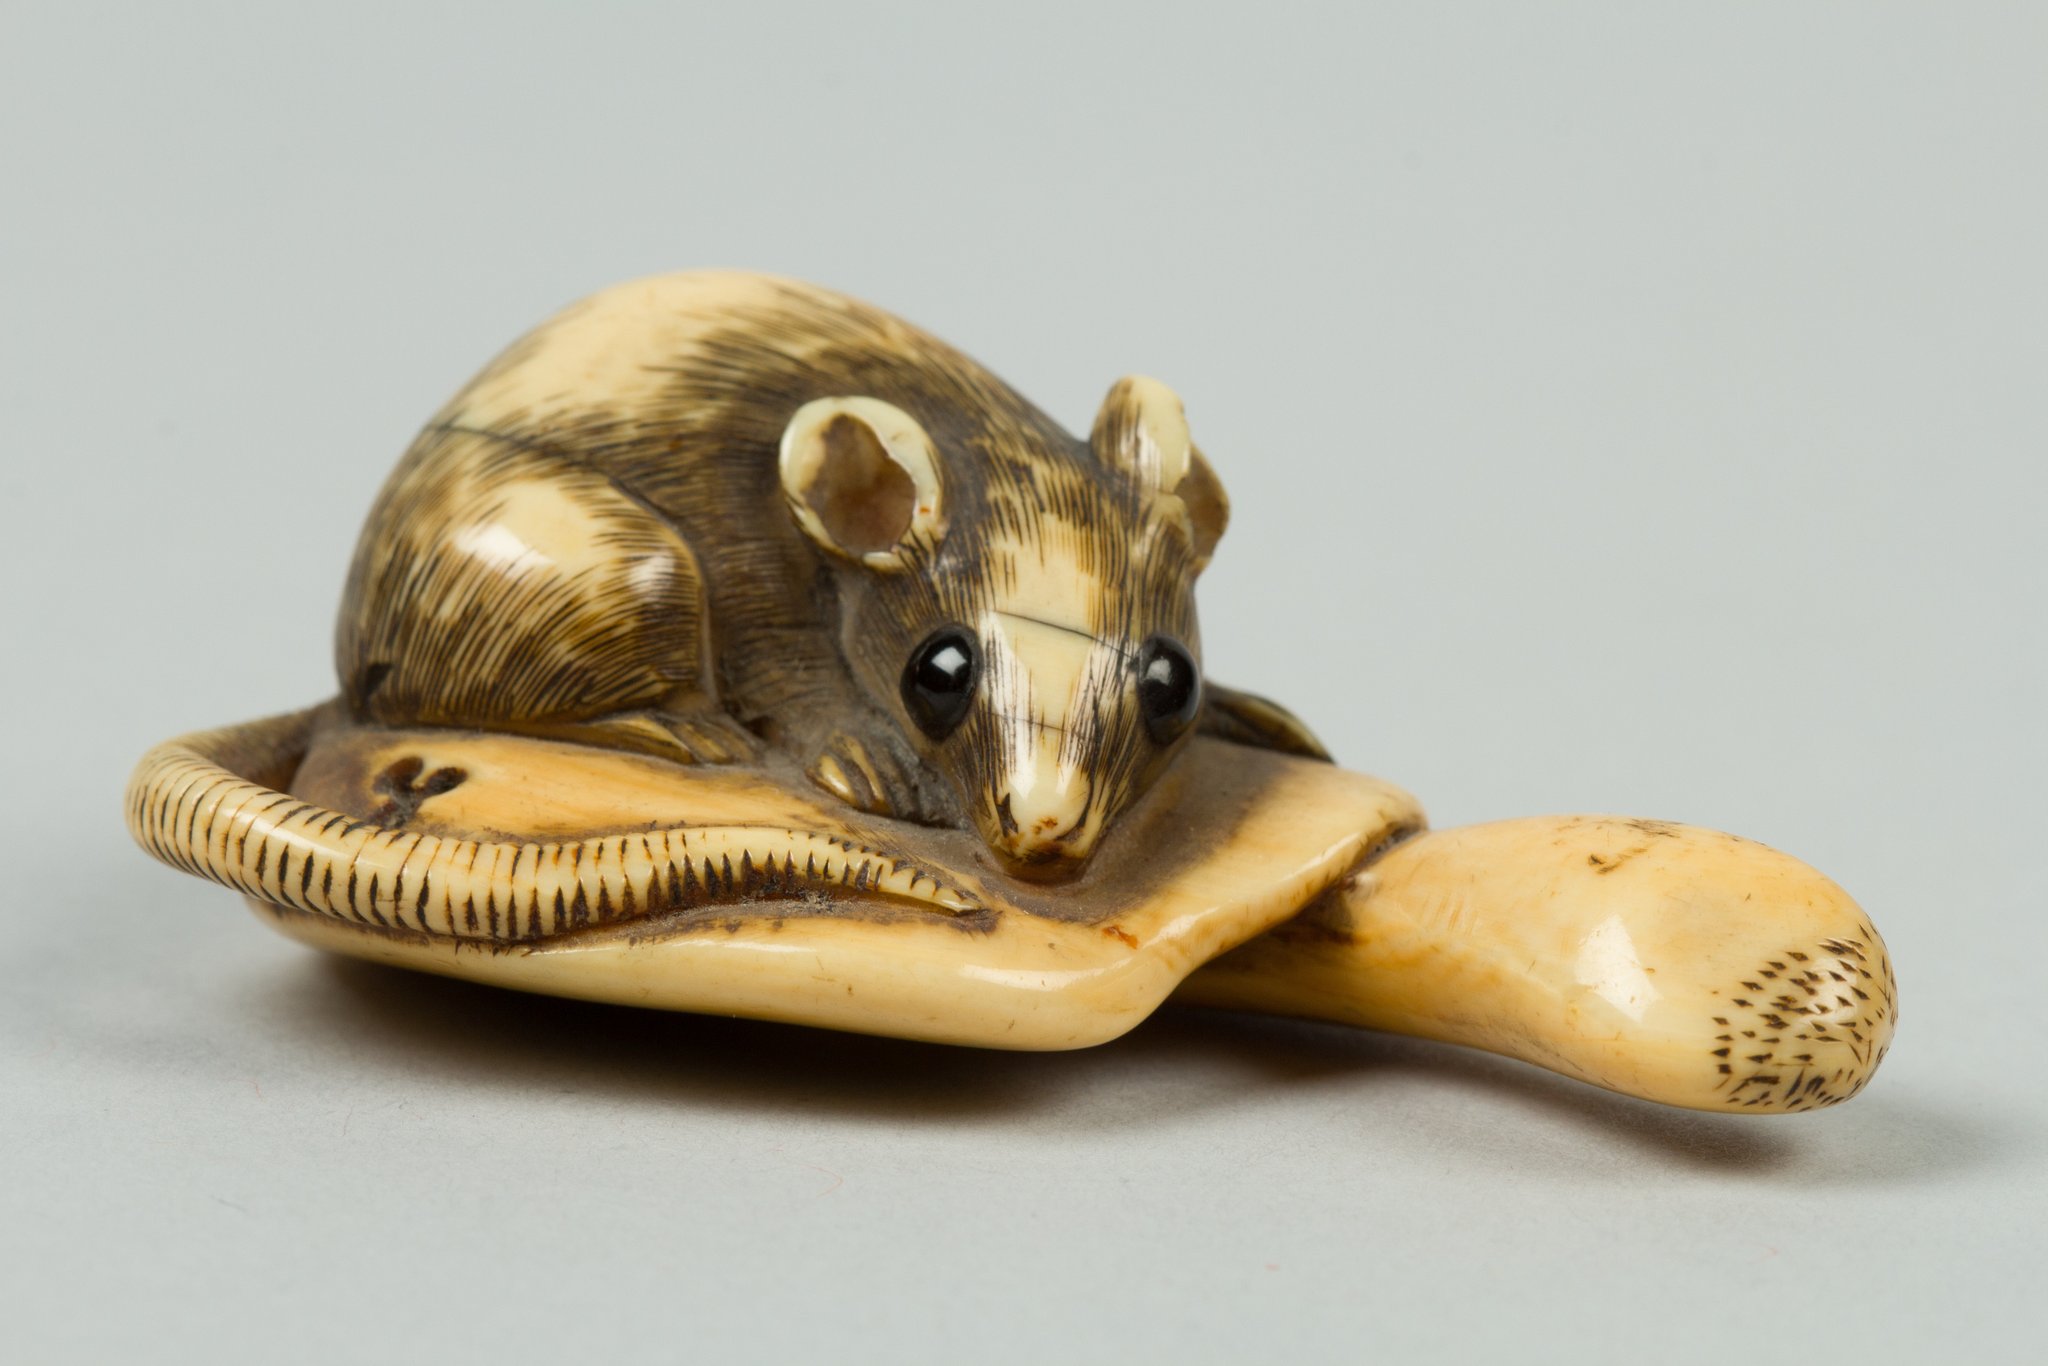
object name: netsuke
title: Netsuke of Mouse on a Mushroom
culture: japanese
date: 1801-1900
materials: ivory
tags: mice